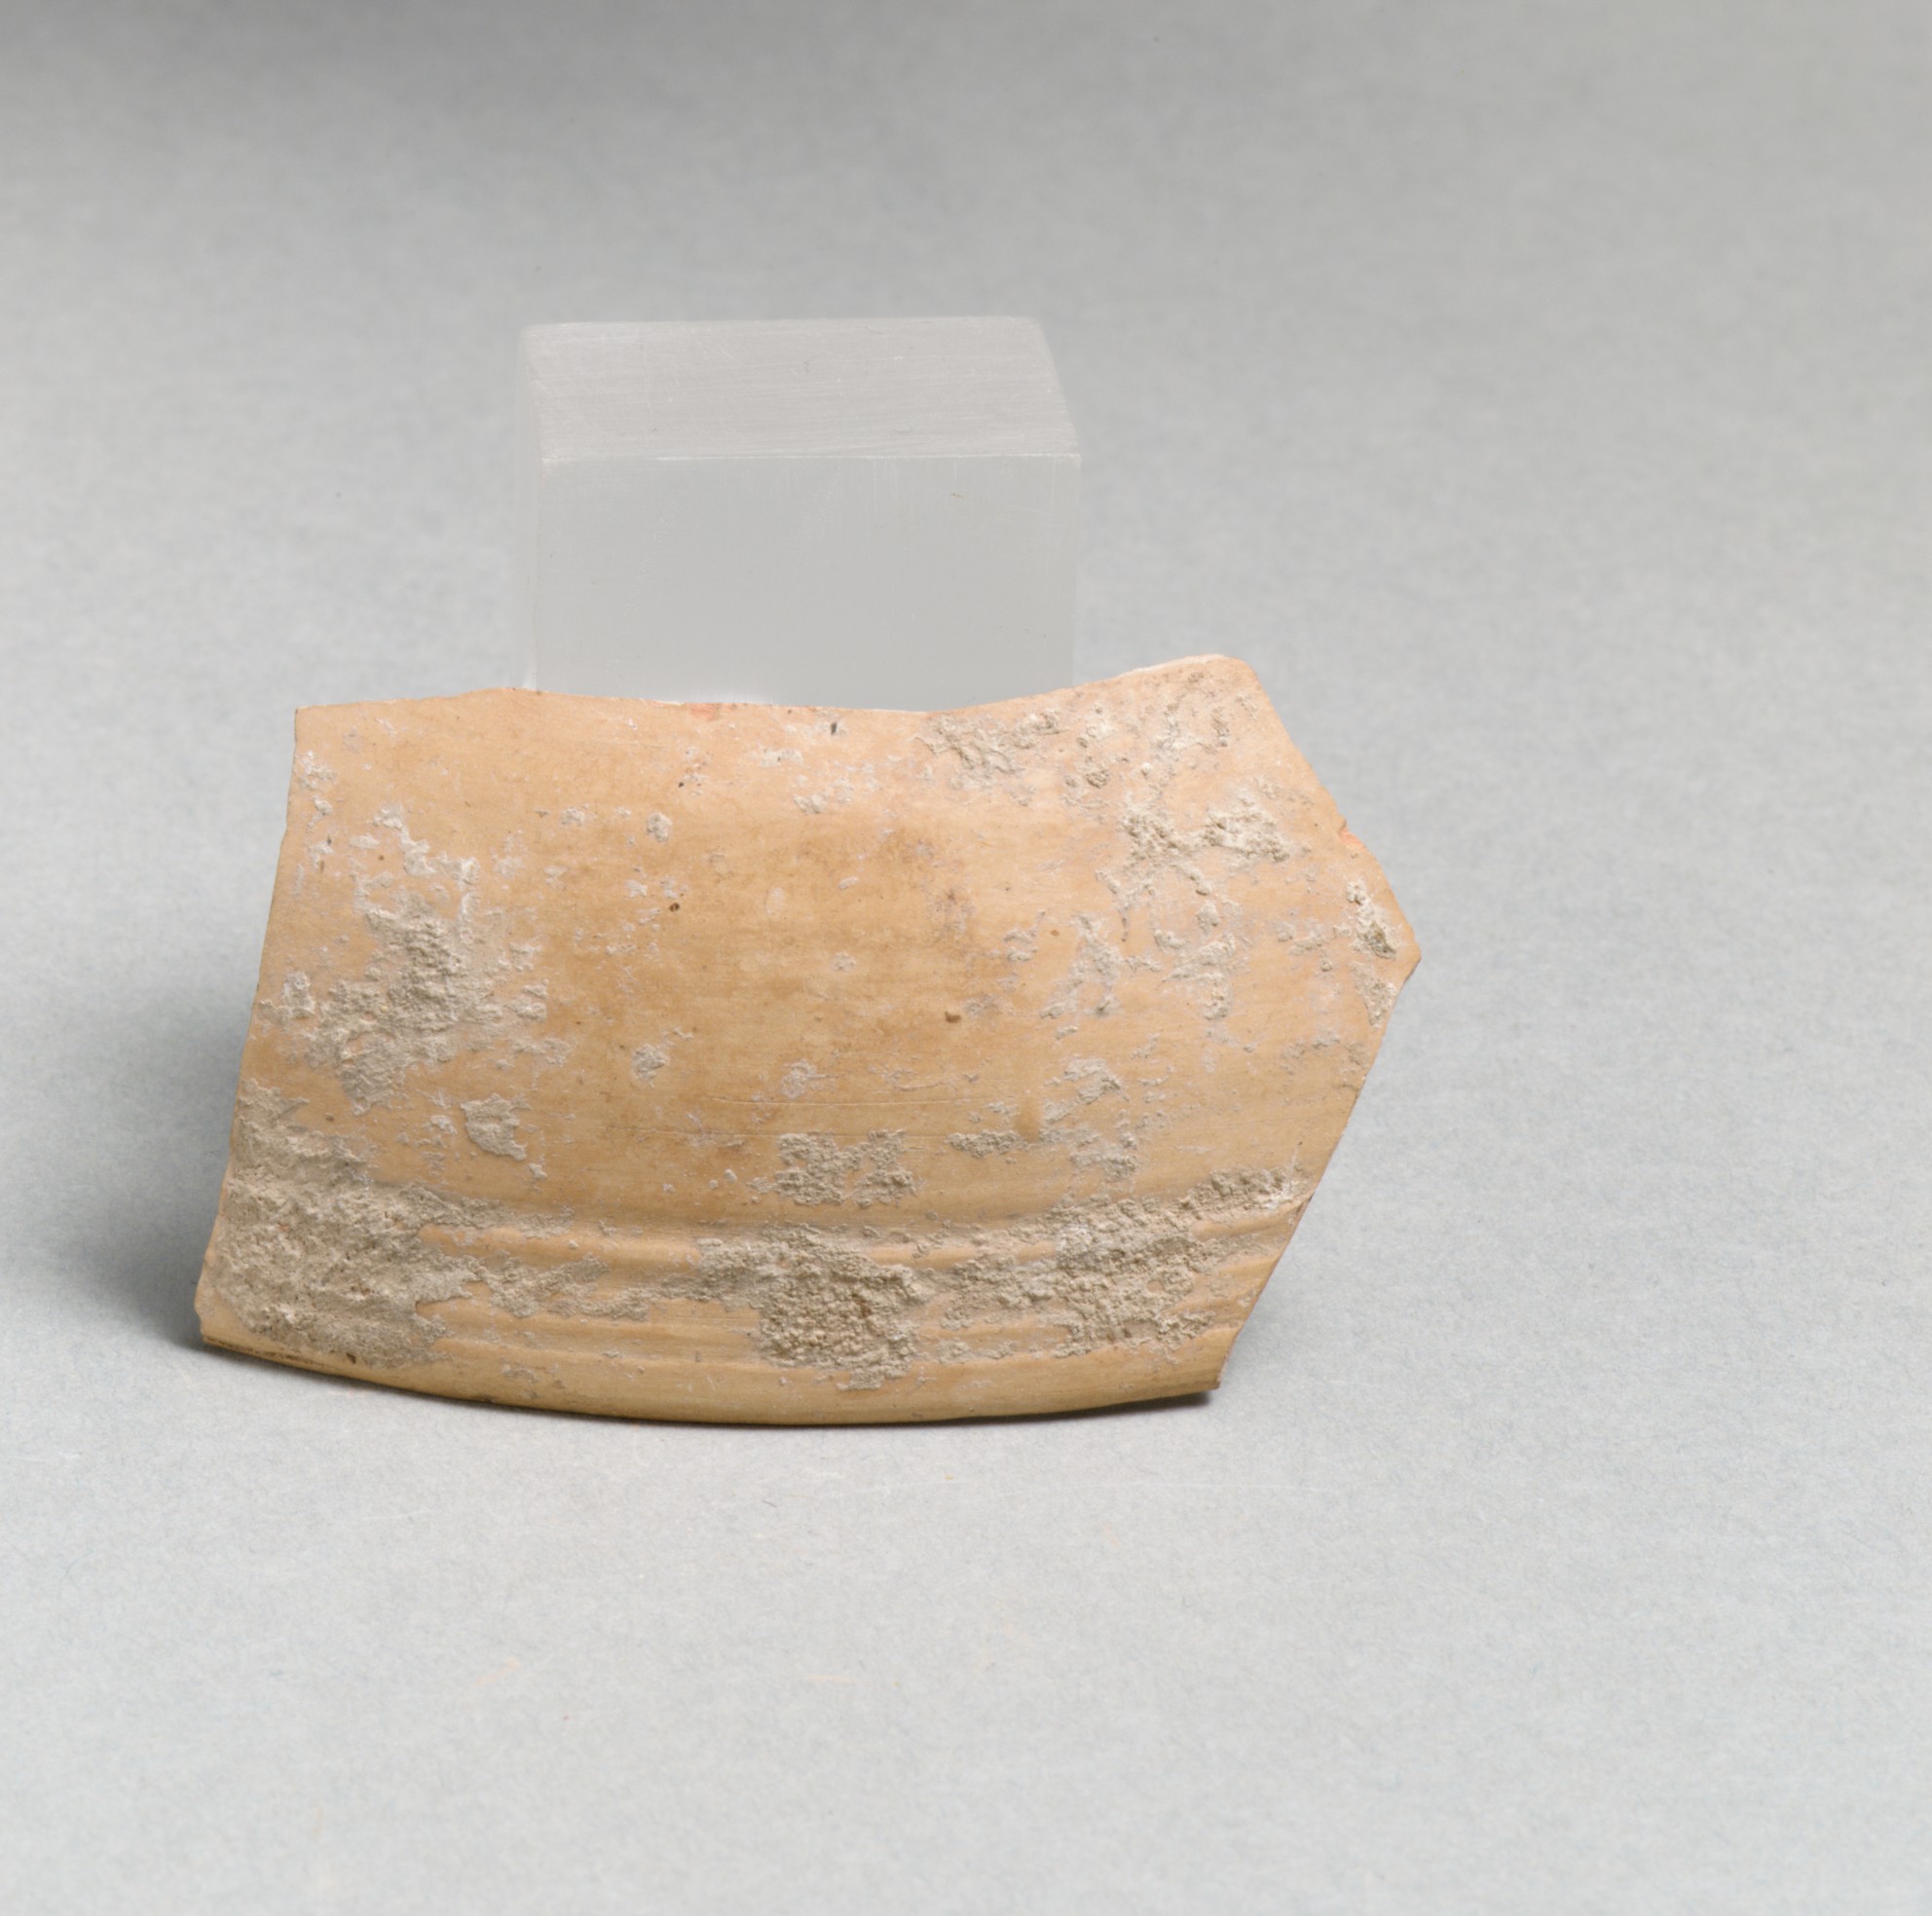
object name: vase fragment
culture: aegean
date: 3000-2000 BCE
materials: terracotta